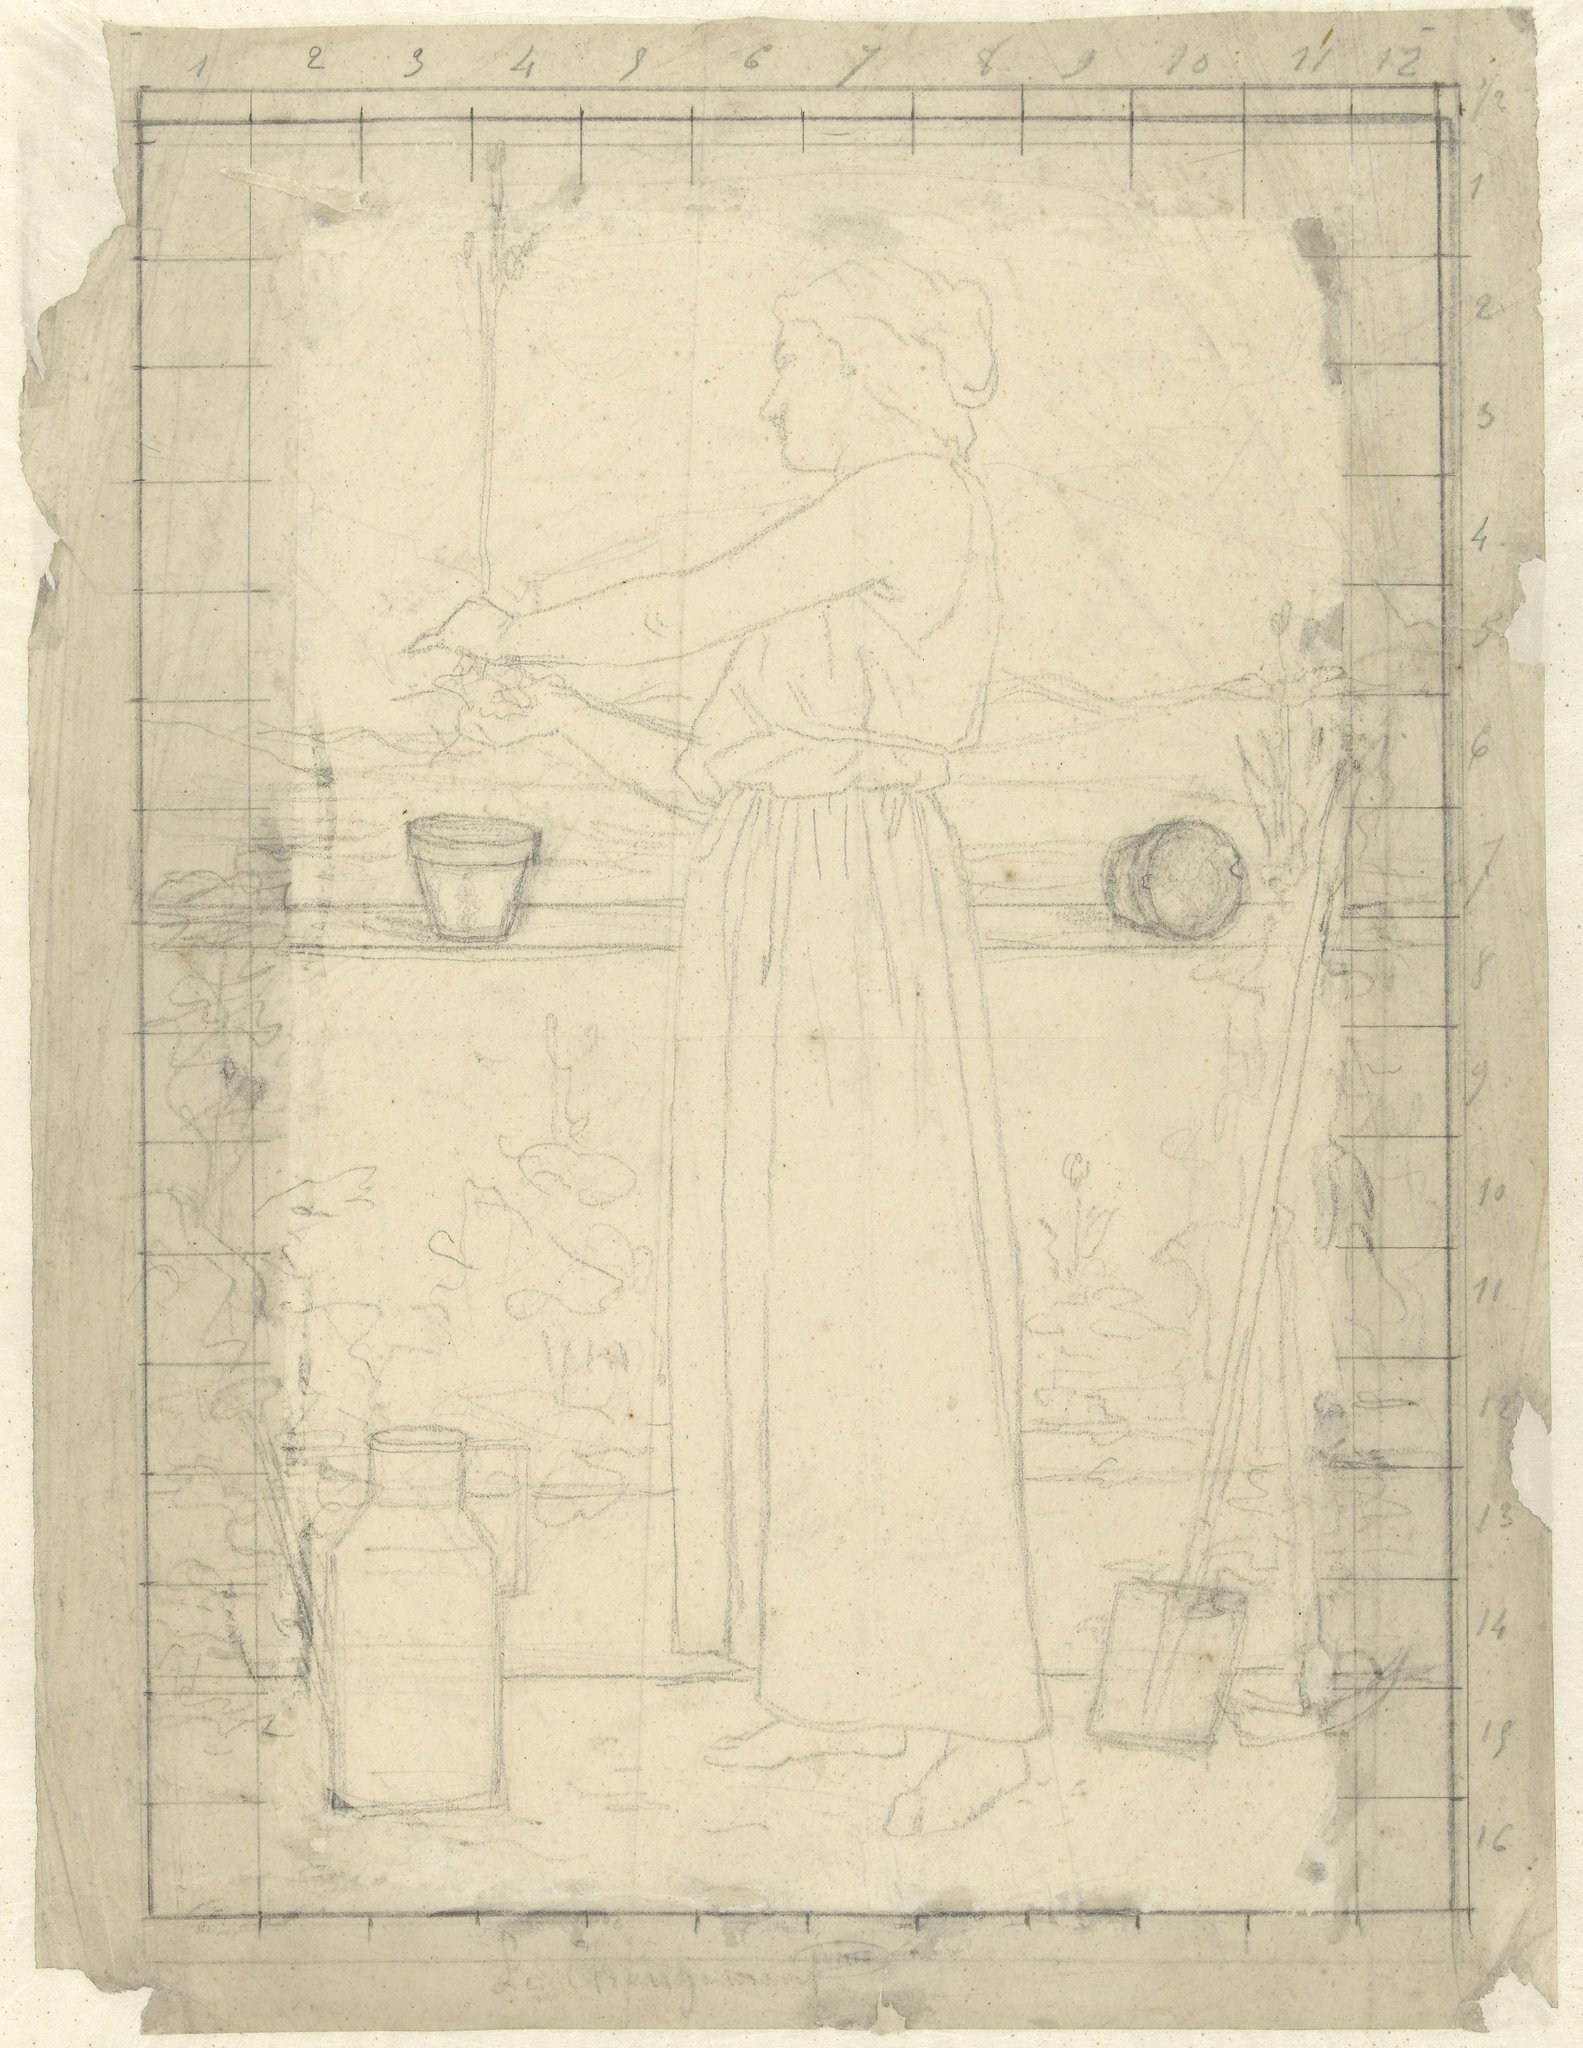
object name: drawing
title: Le Changement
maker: ferdinand roybet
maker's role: draughtsman, print maker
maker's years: 1840-1920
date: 1850-1920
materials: paper, pencil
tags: standing figure - aa - female human figure, potted plants